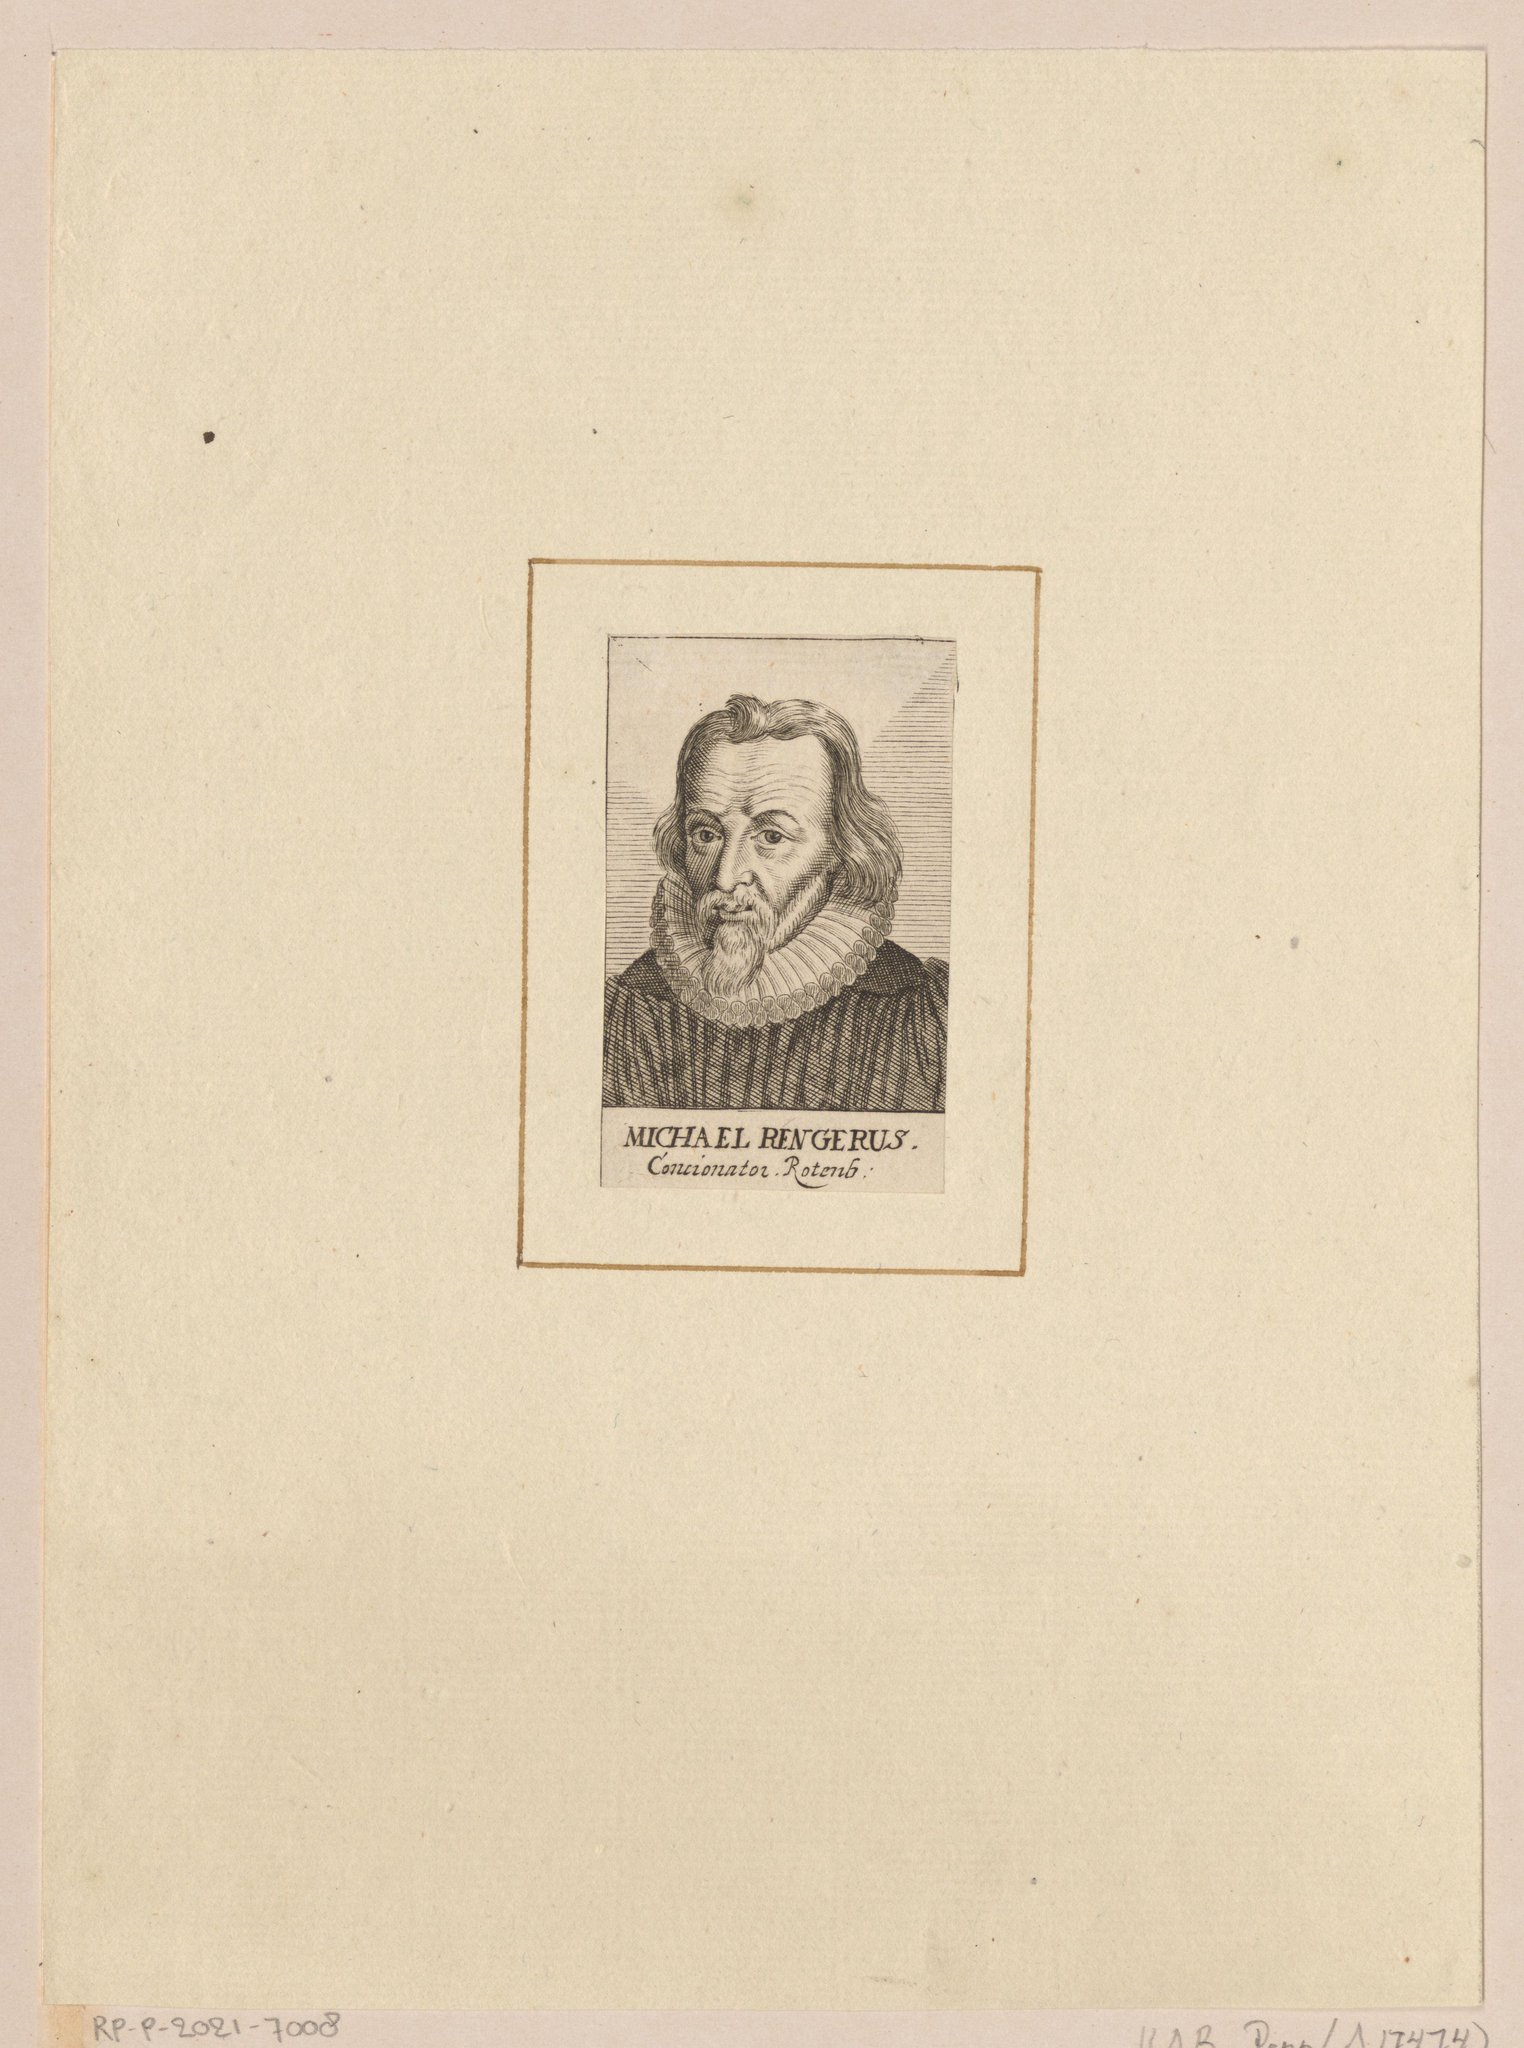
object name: print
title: Portret van Michael Renger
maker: johann franck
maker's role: print maker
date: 1688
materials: paper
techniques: engraving, etching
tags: historical persons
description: Prent mogelijk uit: Freher, Paul. Theatrum virorum eruditione clarorum. Neurenberg: Johann Hoffmann, 1688.